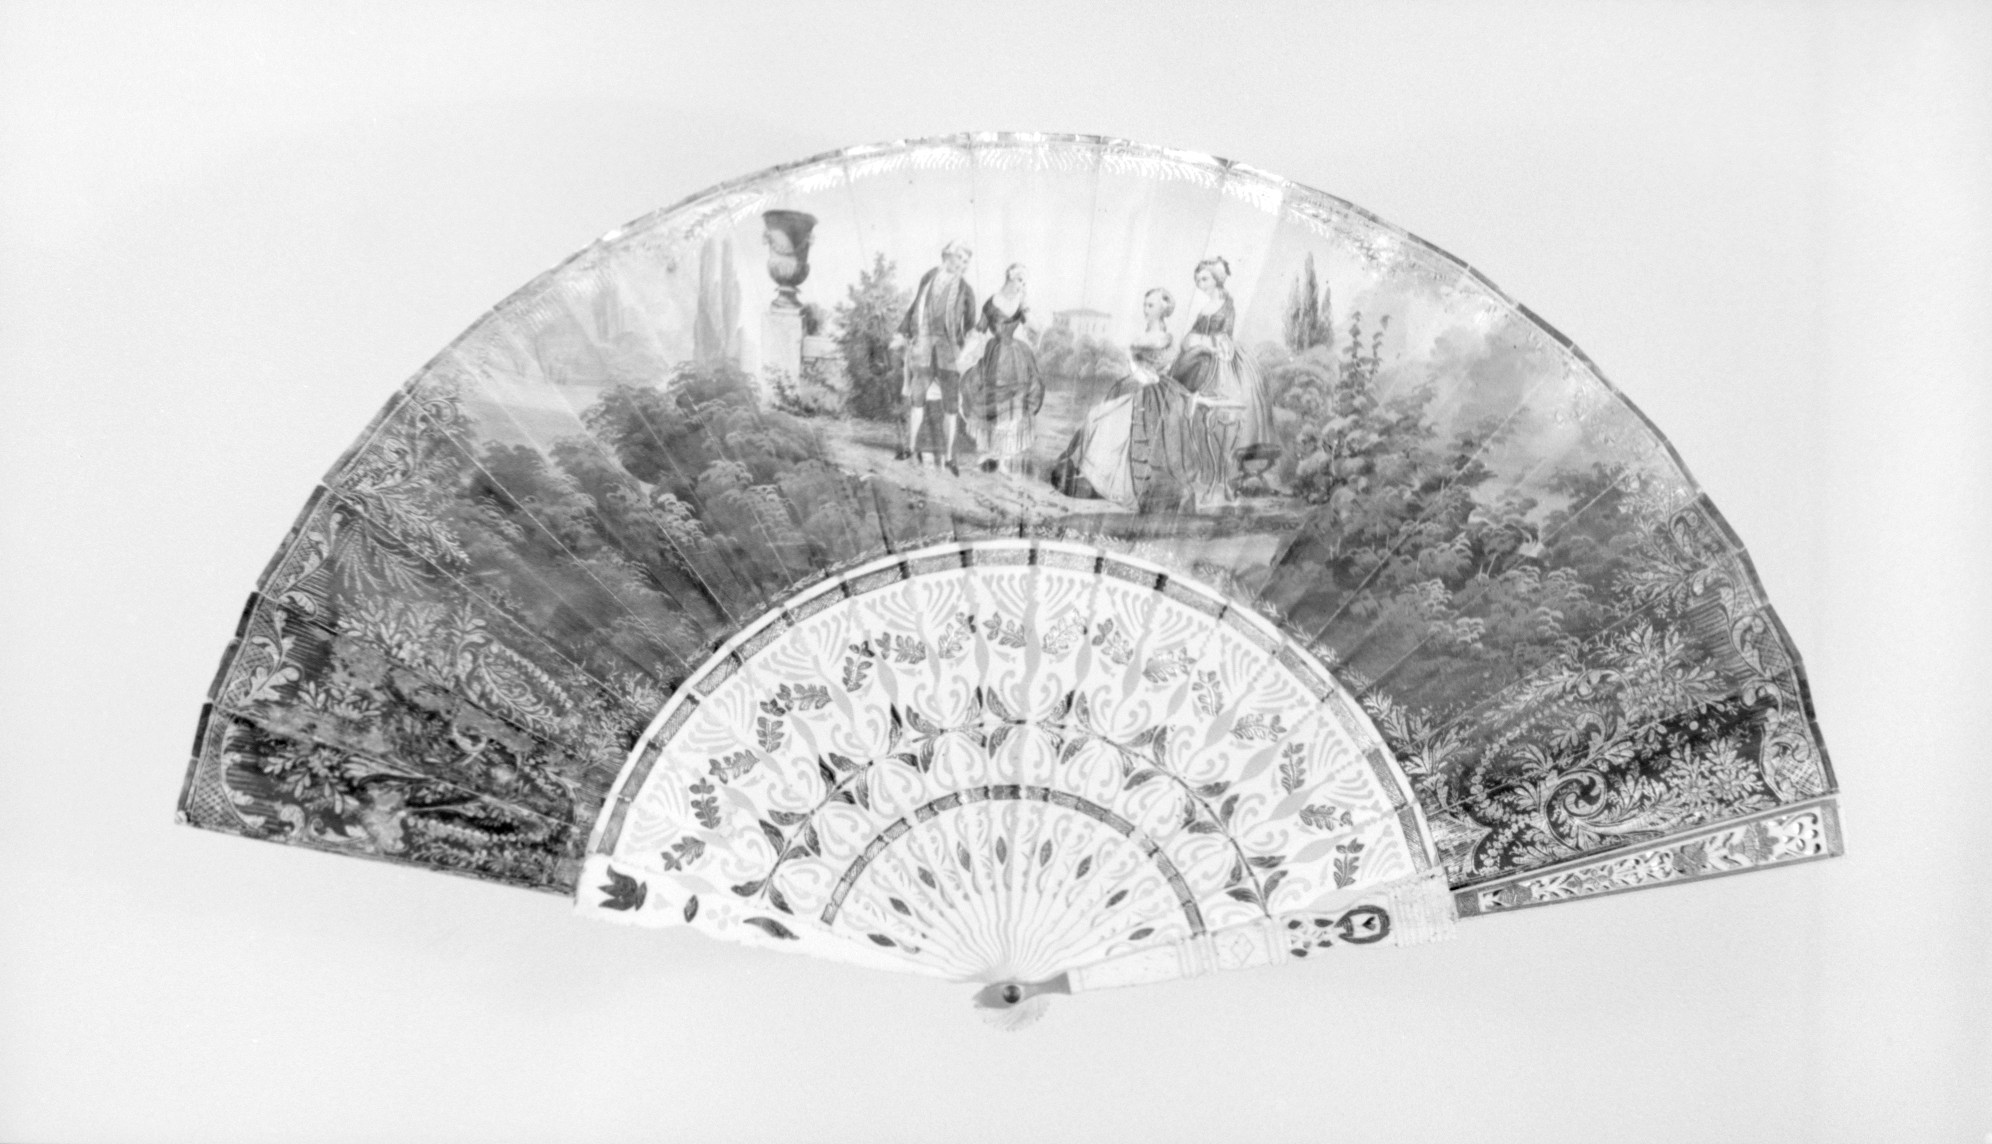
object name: fan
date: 1840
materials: gilt, gold, ivory, metal, mother of pearl, paint, paper, silver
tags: men,women